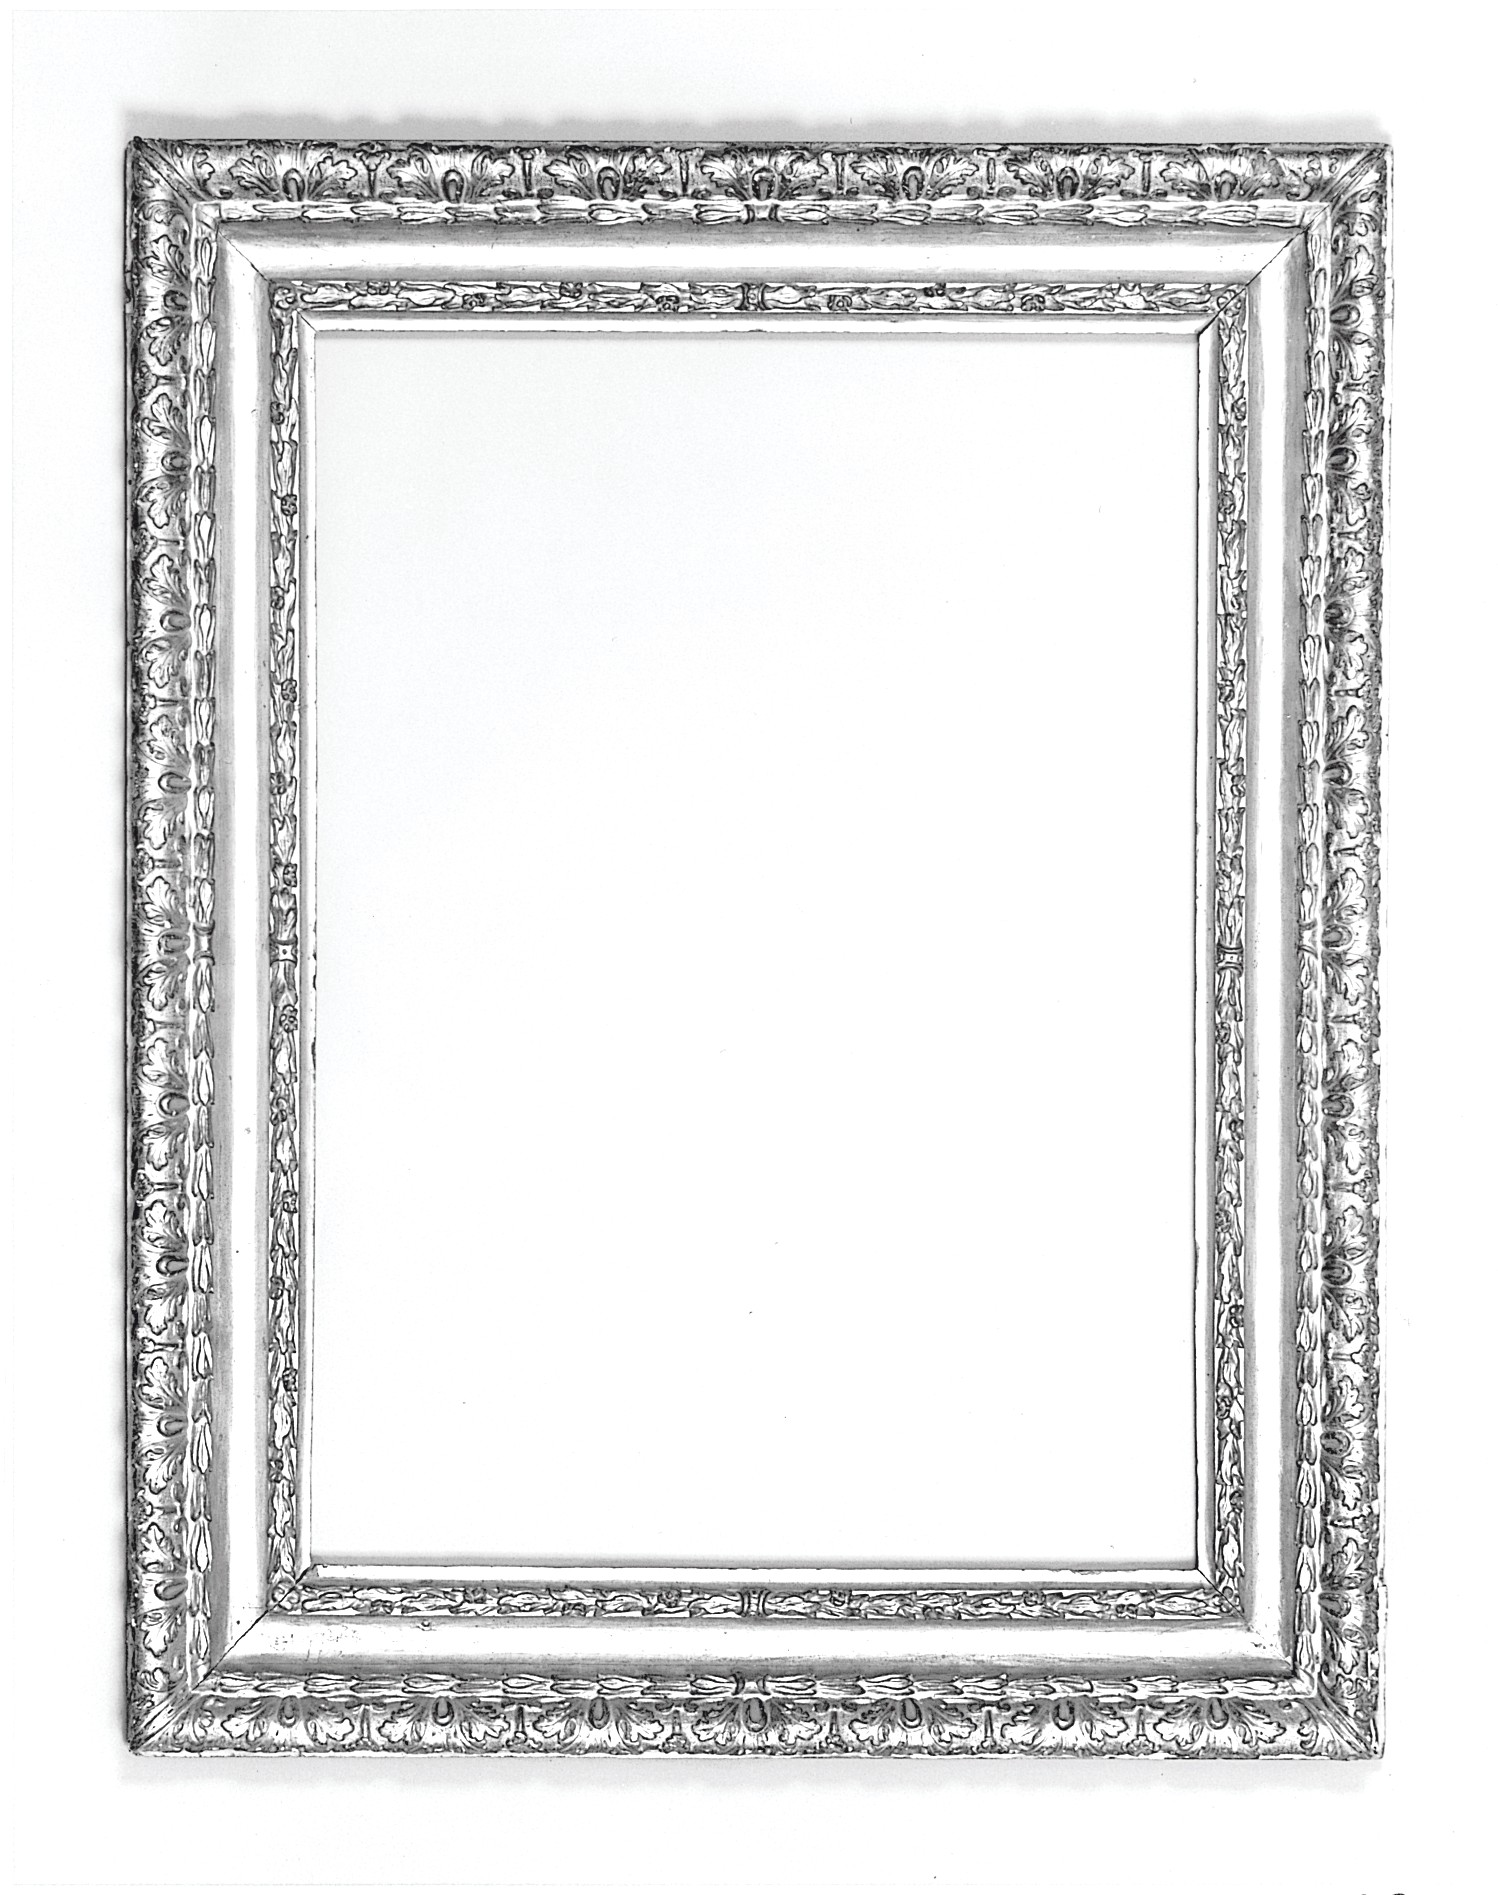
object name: frame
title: Neoclassical frame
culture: italian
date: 1834-1866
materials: wood